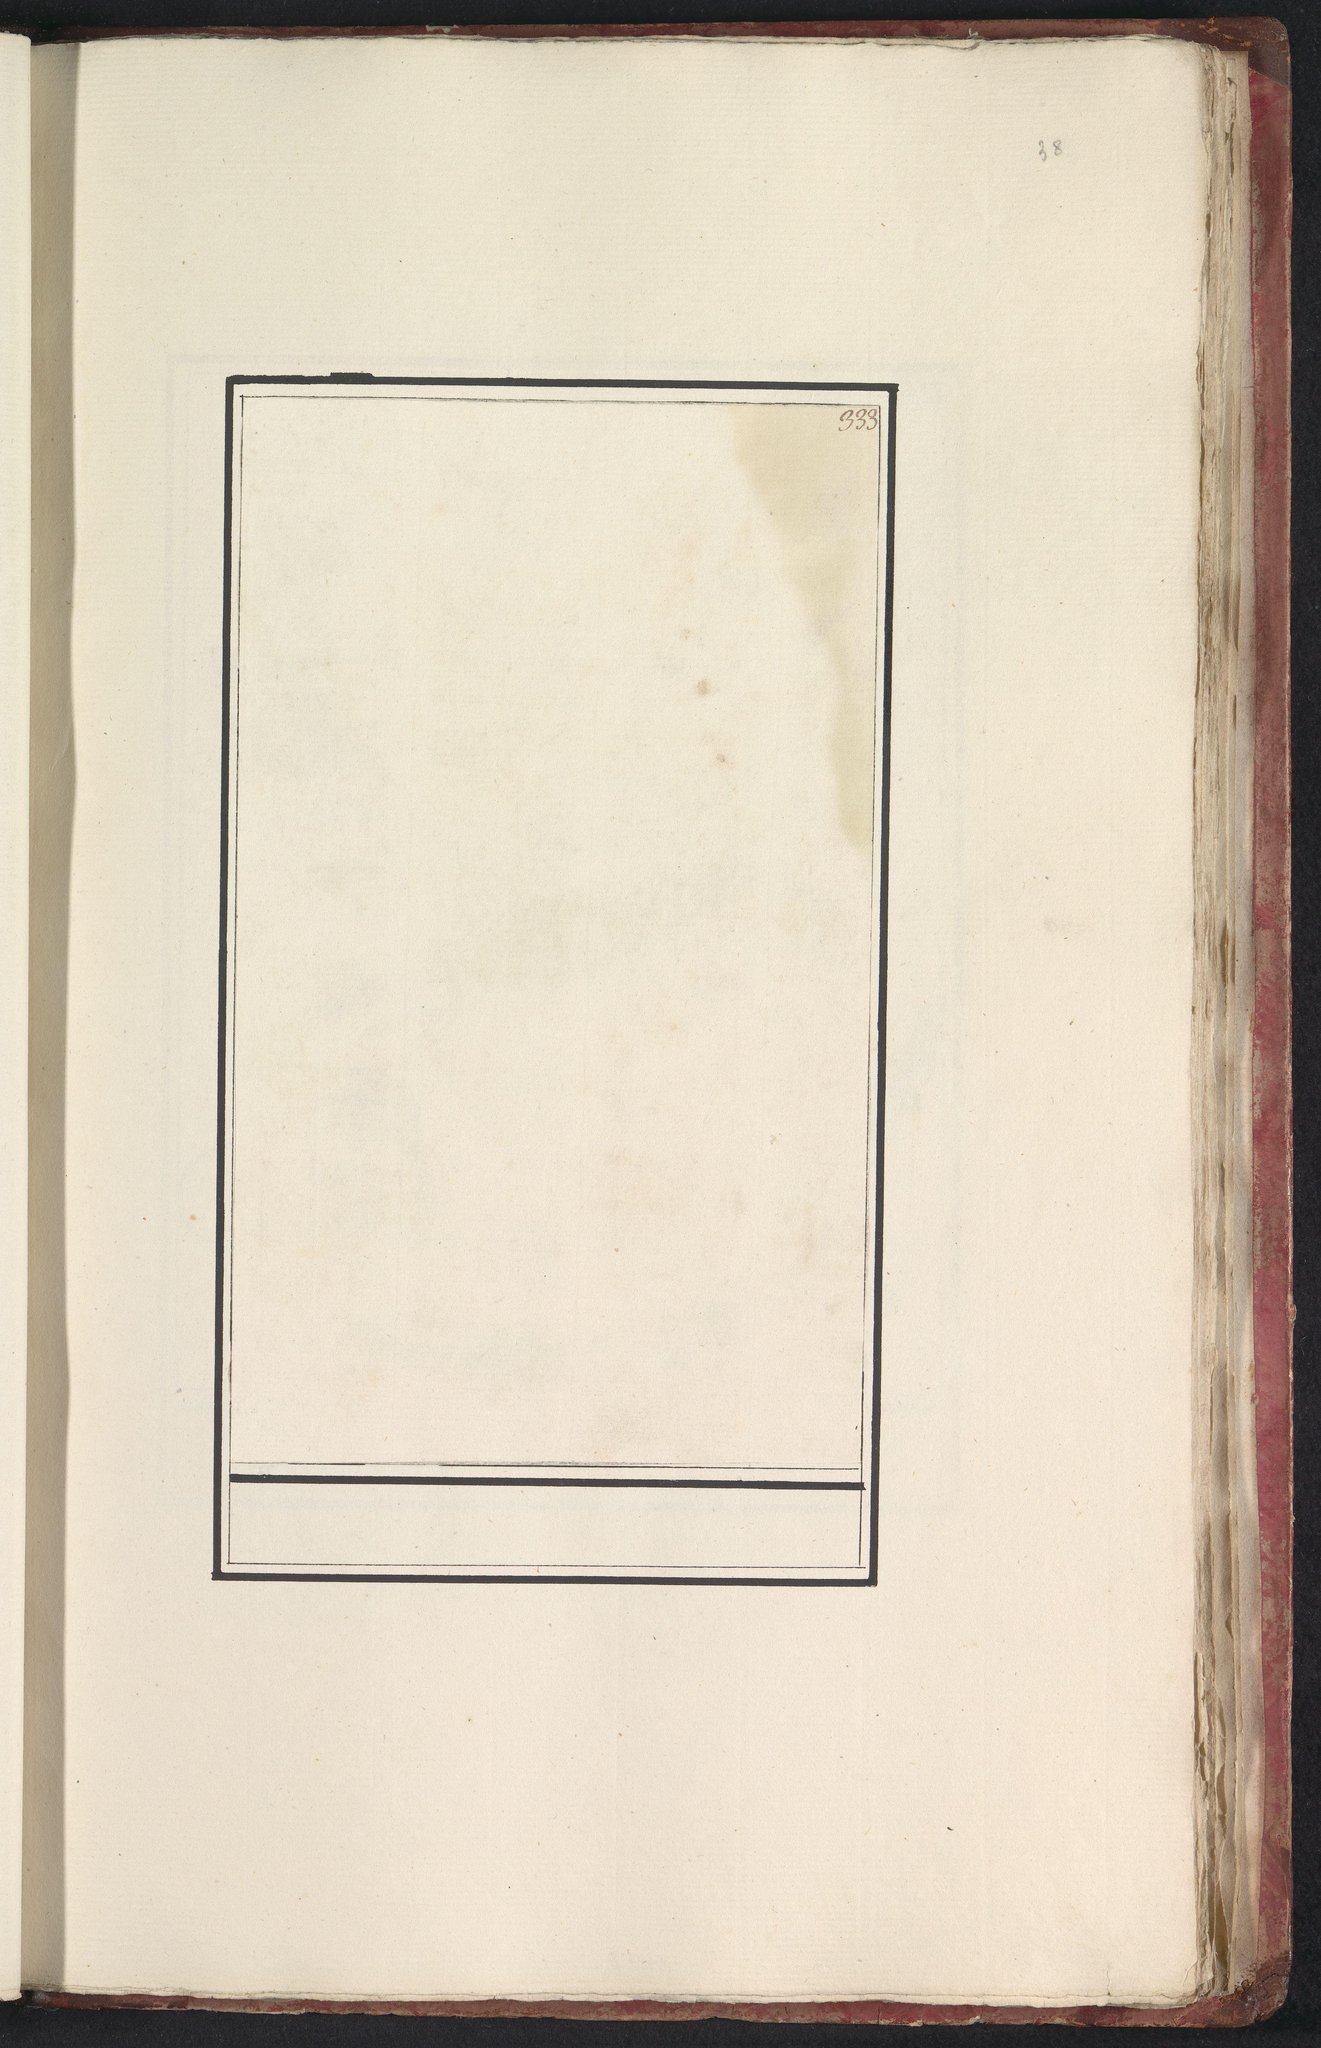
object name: drawing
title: Omlijsting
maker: Anonymous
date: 1809-1814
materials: paper, pencil, watercolor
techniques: brush, pen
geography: southern netherlands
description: Lege omlijsting. Rechtsboven genummerd: 333. Onderdeel van het vierde album met tekeningen van bloemen en paddestoelen. Elfde van twaalf albums met tekeningen van dieren, vogels en planten bekend rond 1600, gemaakt in opdracht van keizer Rudolf II. Met toelichting in Nederlands, Latijn en Frans.